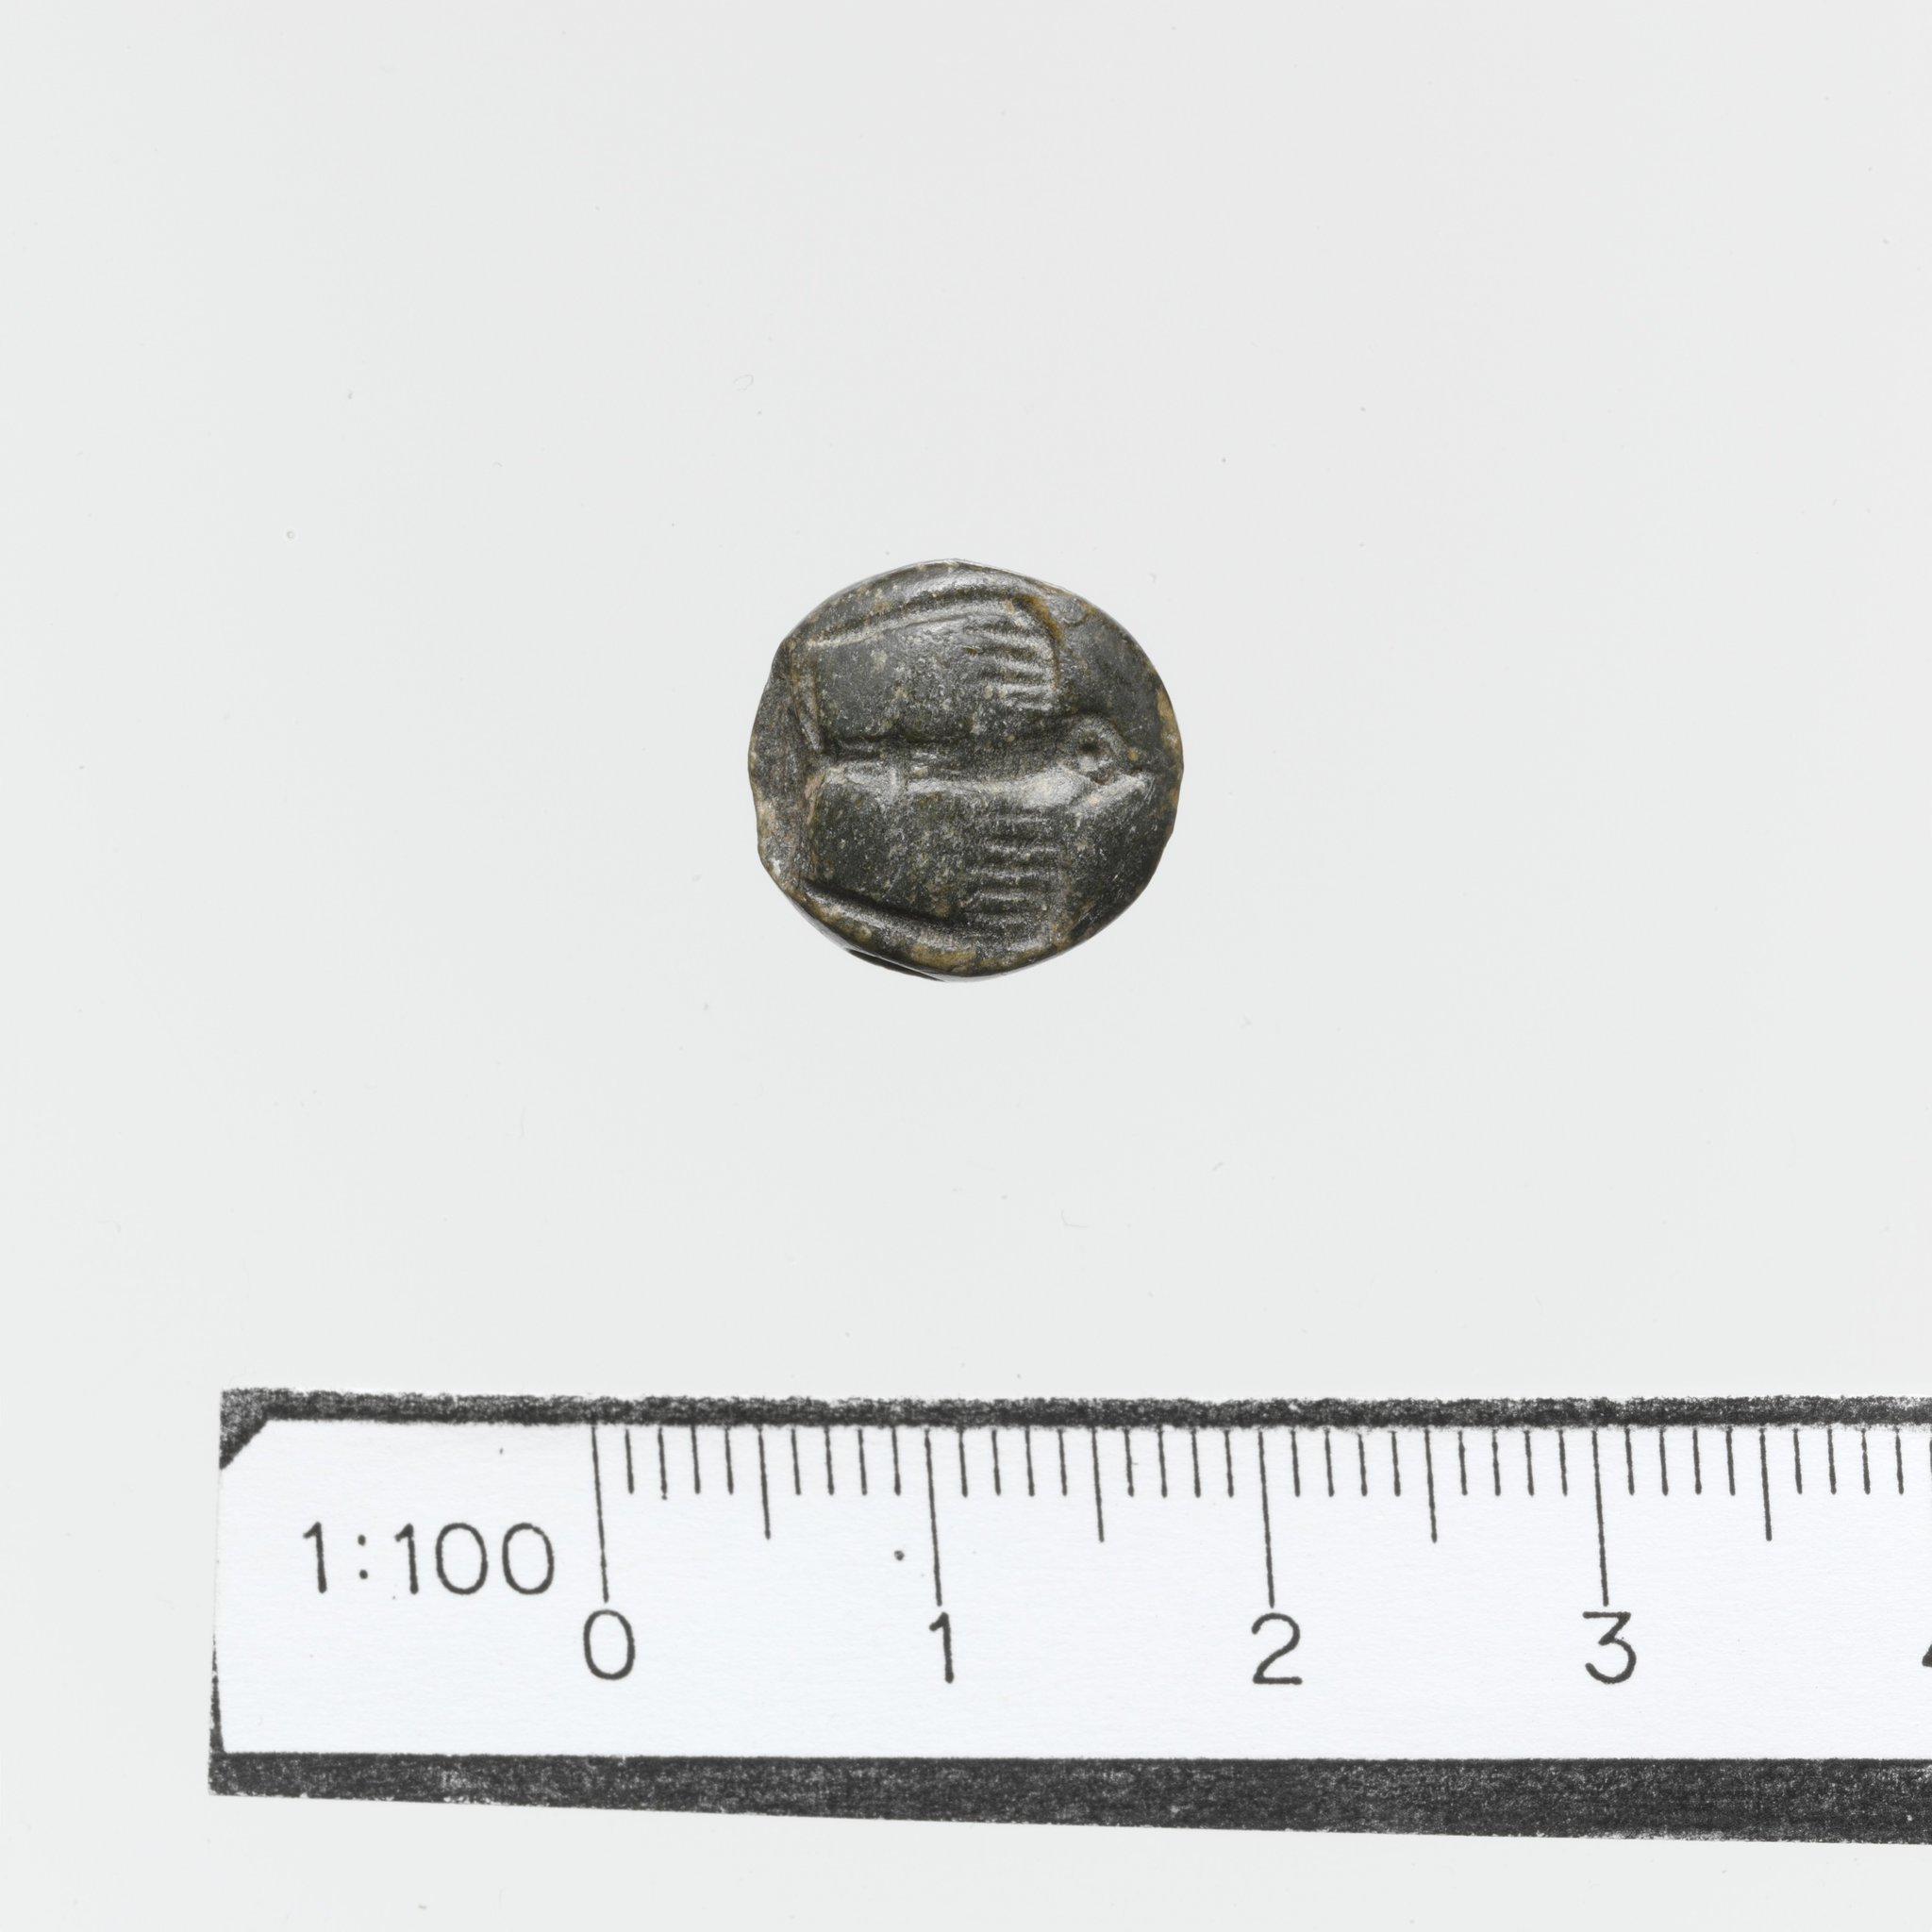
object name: seal, lentoid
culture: minoan, crete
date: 1600-1450 BCE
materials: stone